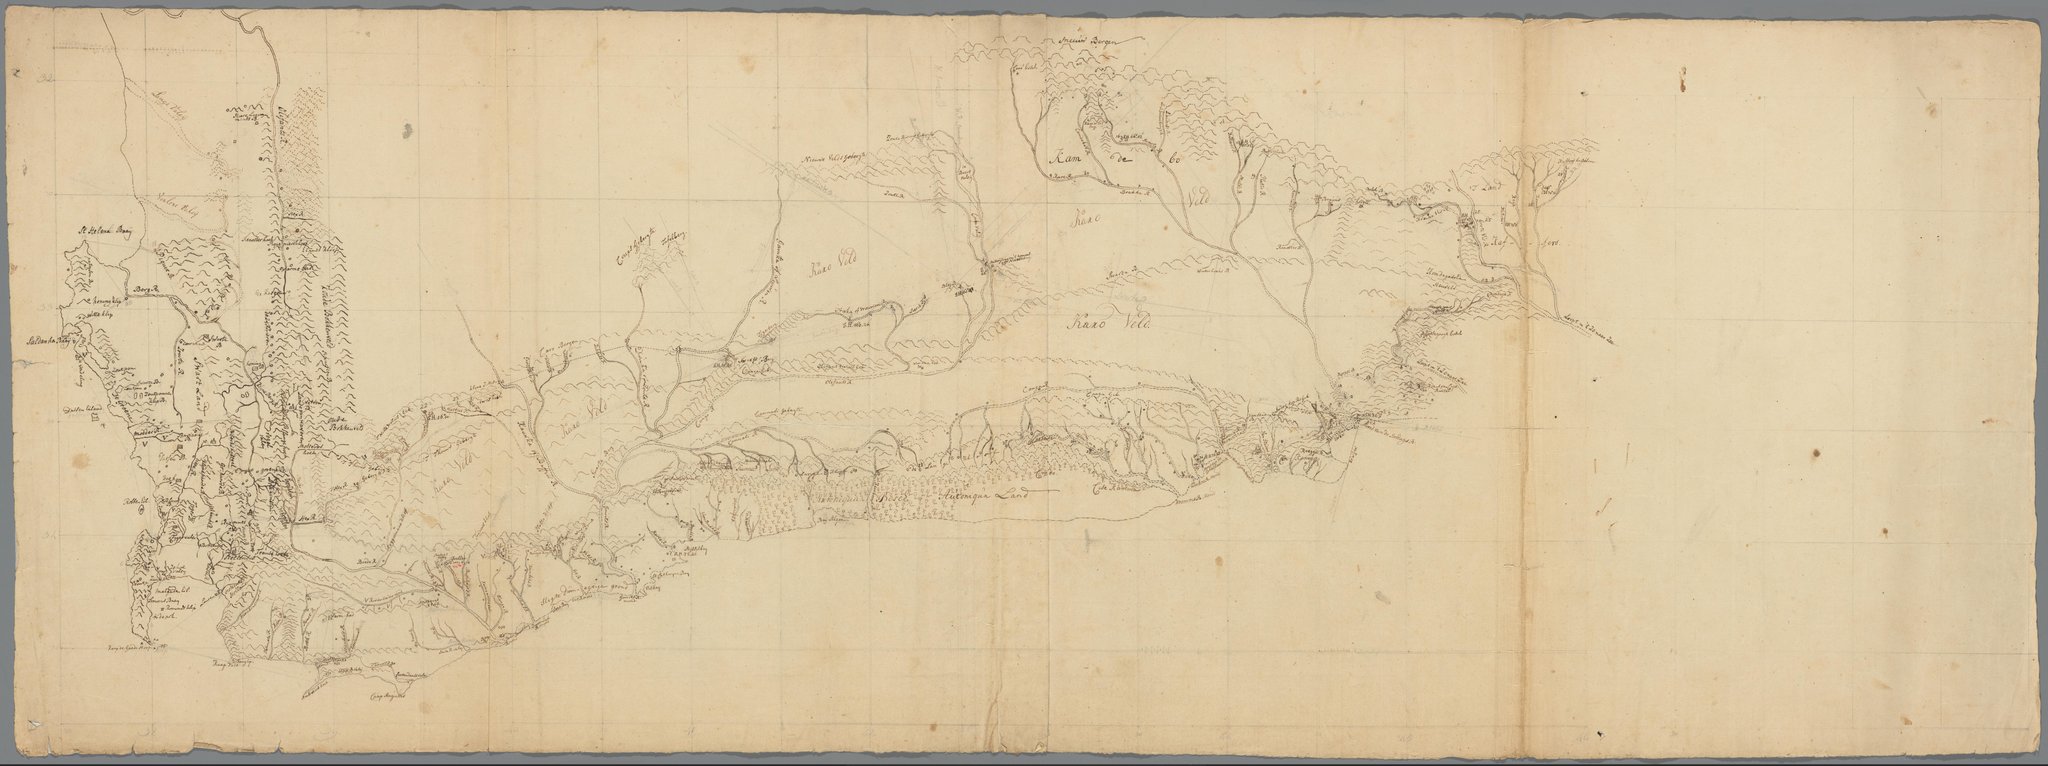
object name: drawing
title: Getekende kaart van de Kaapkolonie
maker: Anonymous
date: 1775-1799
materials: ink, paper, pencil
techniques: pen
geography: south africa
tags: cape of good hope, maps of separate countries or regions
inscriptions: label: ‘A16’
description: Getekende kaart van de Kaapkolonie. Mogelijk gerelateerd aan de reizen van Hendrik Swellengrebel iin 1776-1777. Met lengte- en breedtegraden.